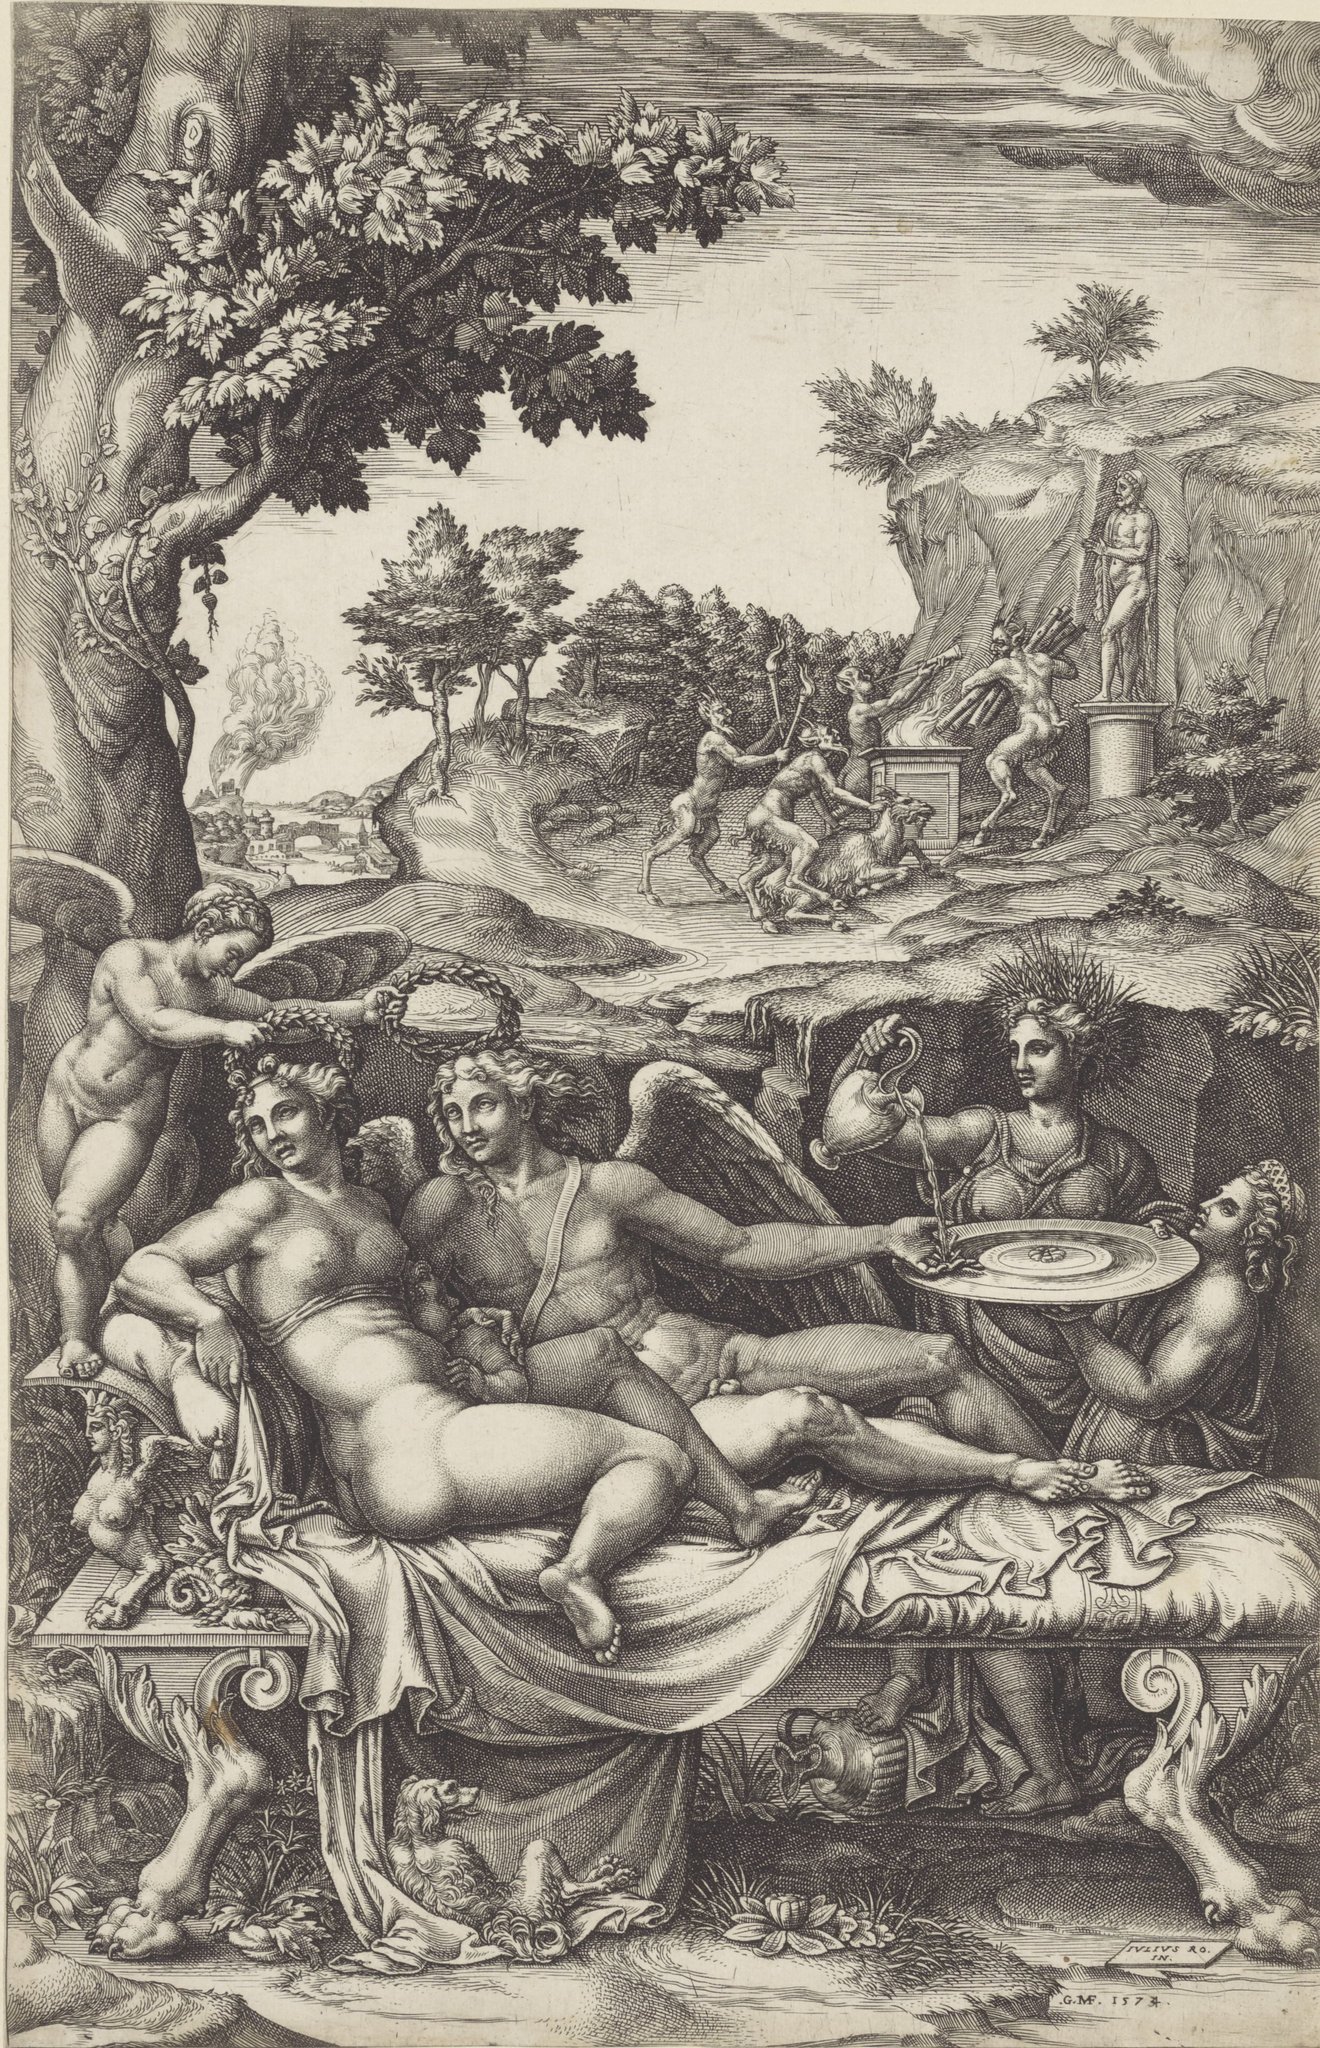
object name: print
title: Amor en Psyche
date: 1574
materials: paper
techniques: engraving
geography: mantua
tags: cupid and psyche as lovers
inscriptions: collector's mark: Lugt 240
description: Amor en Psyche liggen samen met hun kind (Voluptas) op een chaise longue in een landschap. Een gevleugelde figuur houdt lauwerkransen boven de hoofden van Amor en Psyche. Rechts giet Ceres water op de hand van Amor. Zijn hand leunt op een schaal die wordt gedragen door Juno. Op de achtergrond een groep saters die een geit offeren voor een godenbeeld. Op de voorgrond ligt een hond.